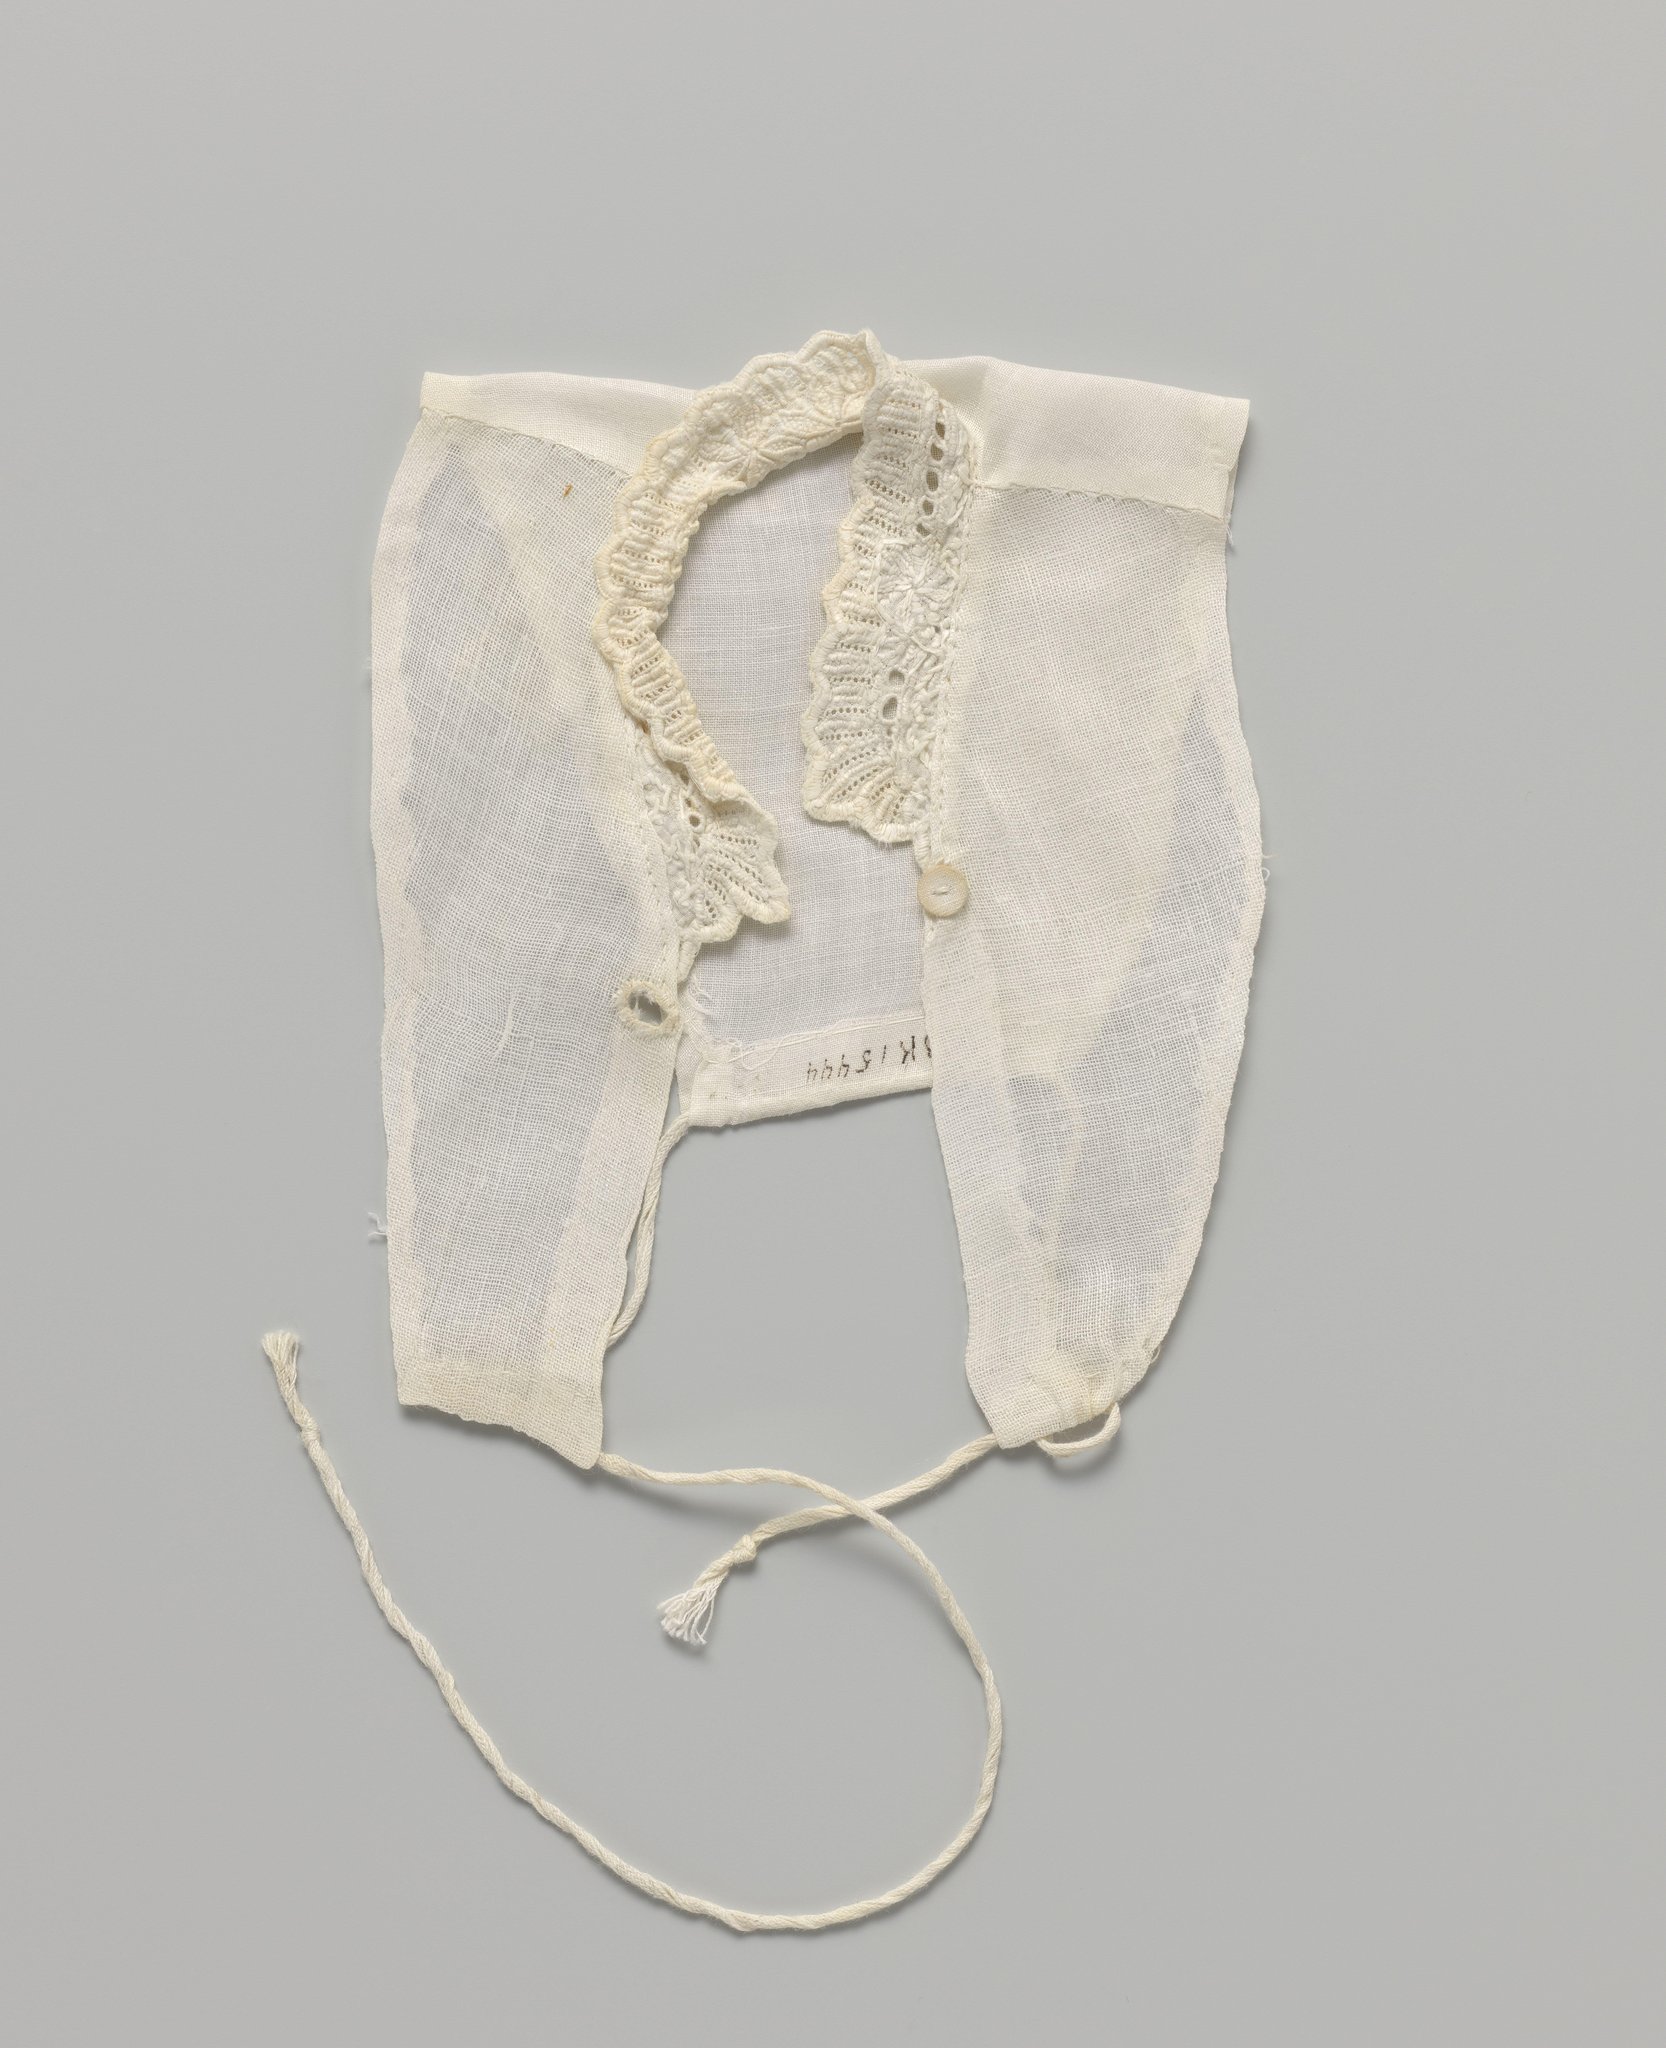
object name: omslagdoek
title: Witte omslagdoek afgezet met kant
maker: Anonymous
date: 1850-1920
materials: plastic, textile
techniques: needle lace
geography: netherlands